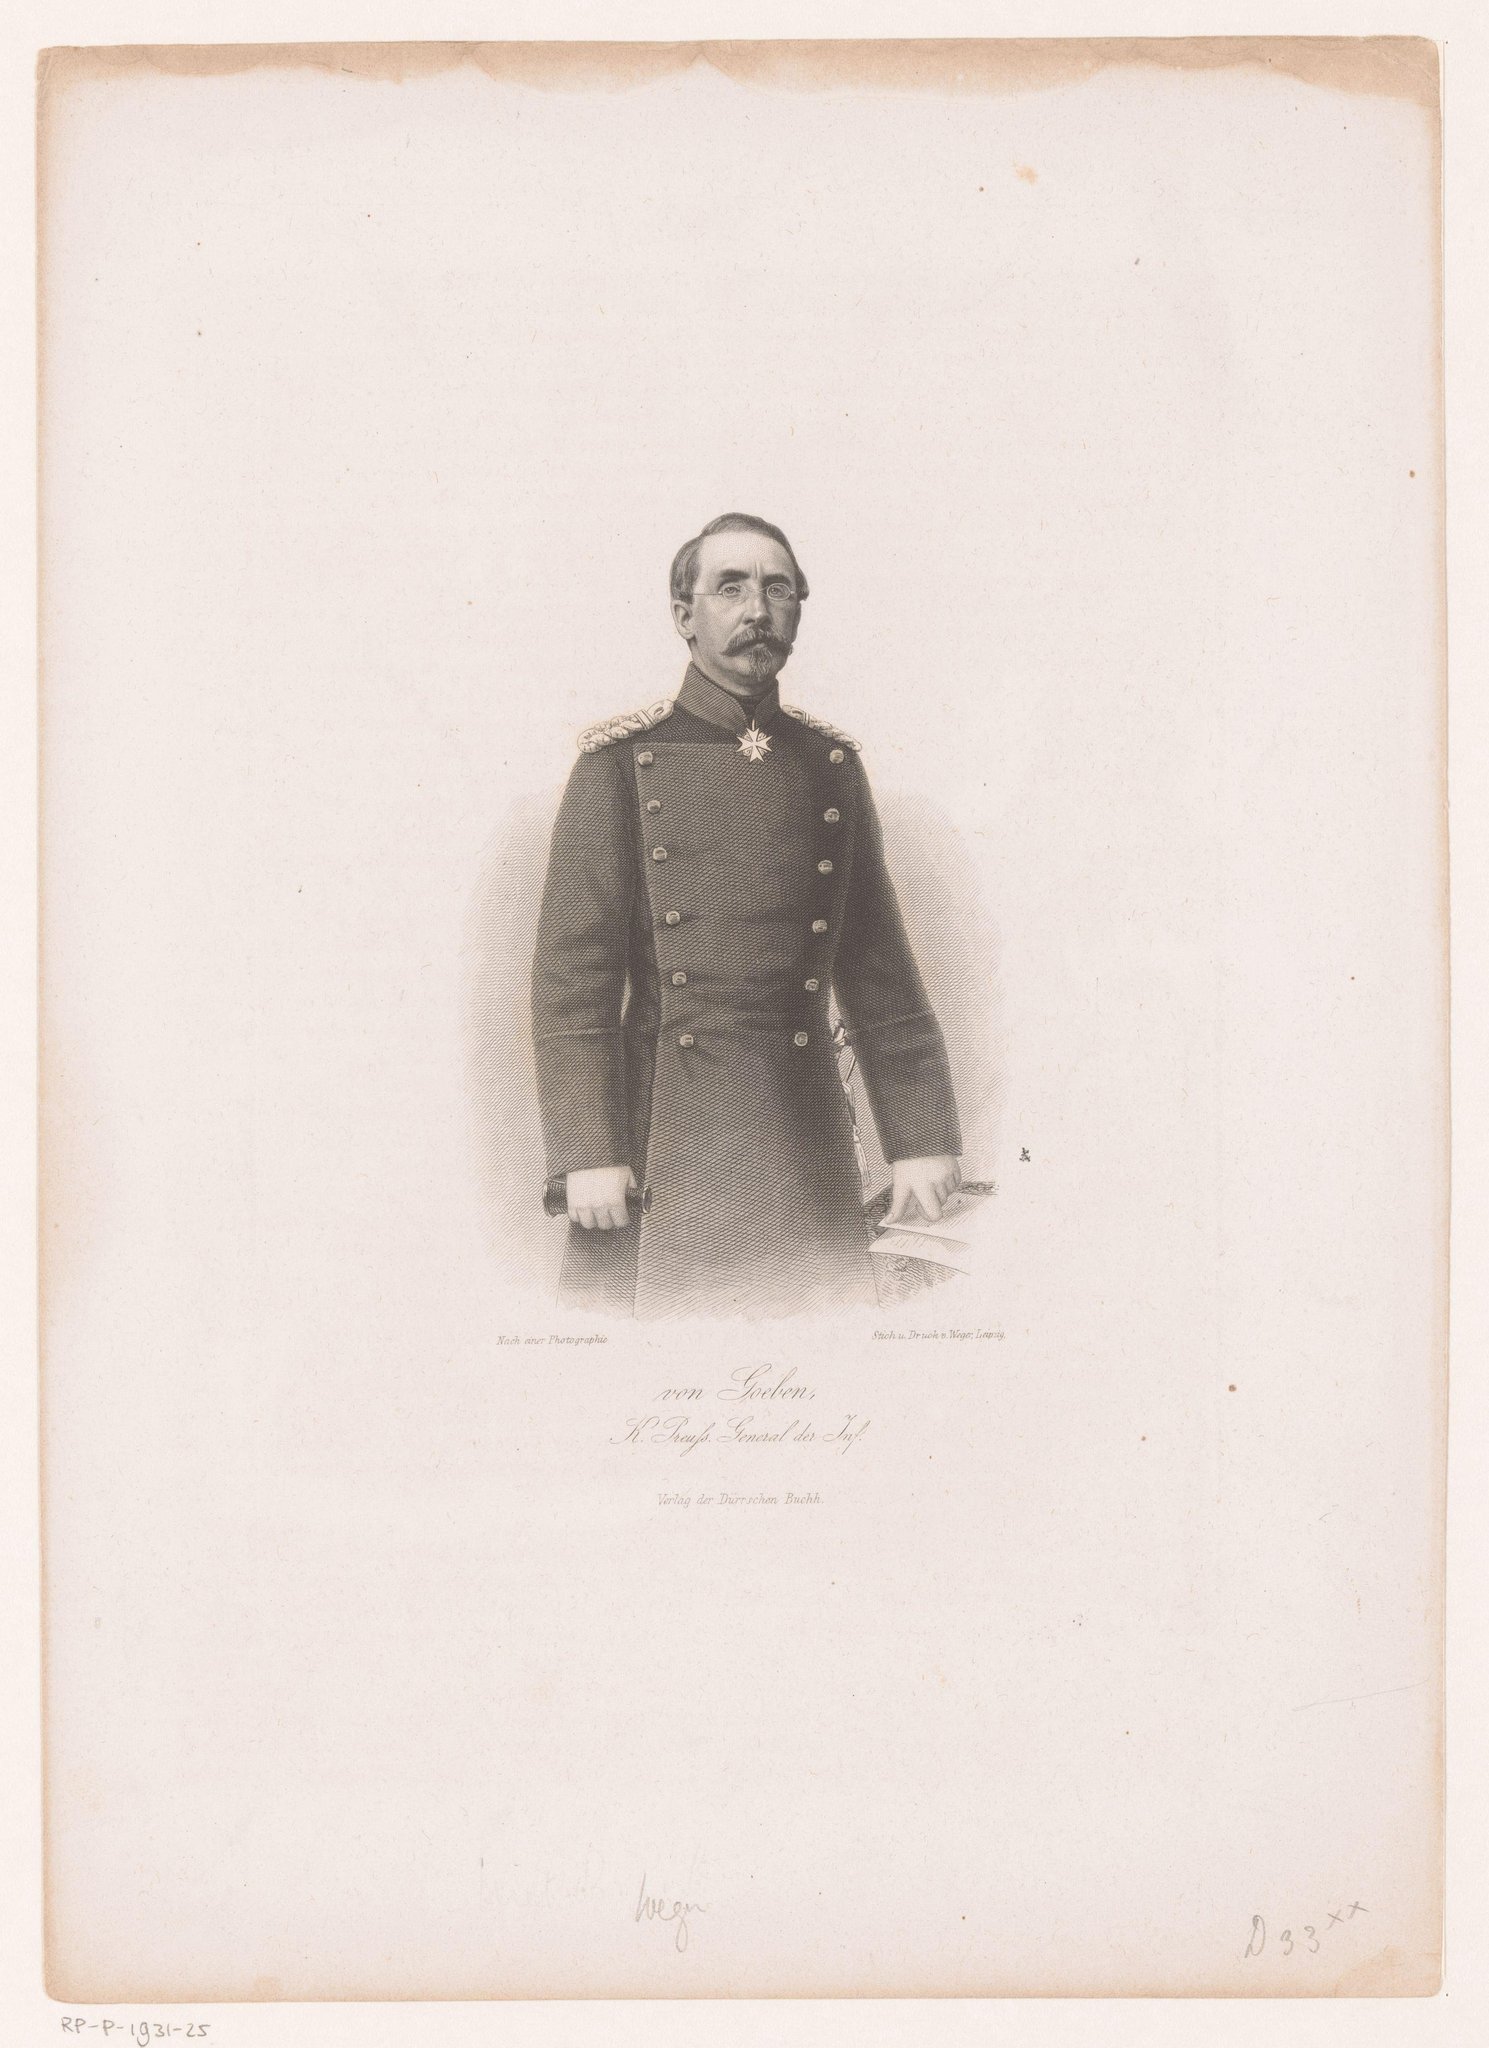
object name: print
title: Portret van August von Goeben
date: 1849-1892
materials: paper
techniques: engraving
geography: leipzig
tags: historical persons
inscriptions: collector's mark: Lugt 2228